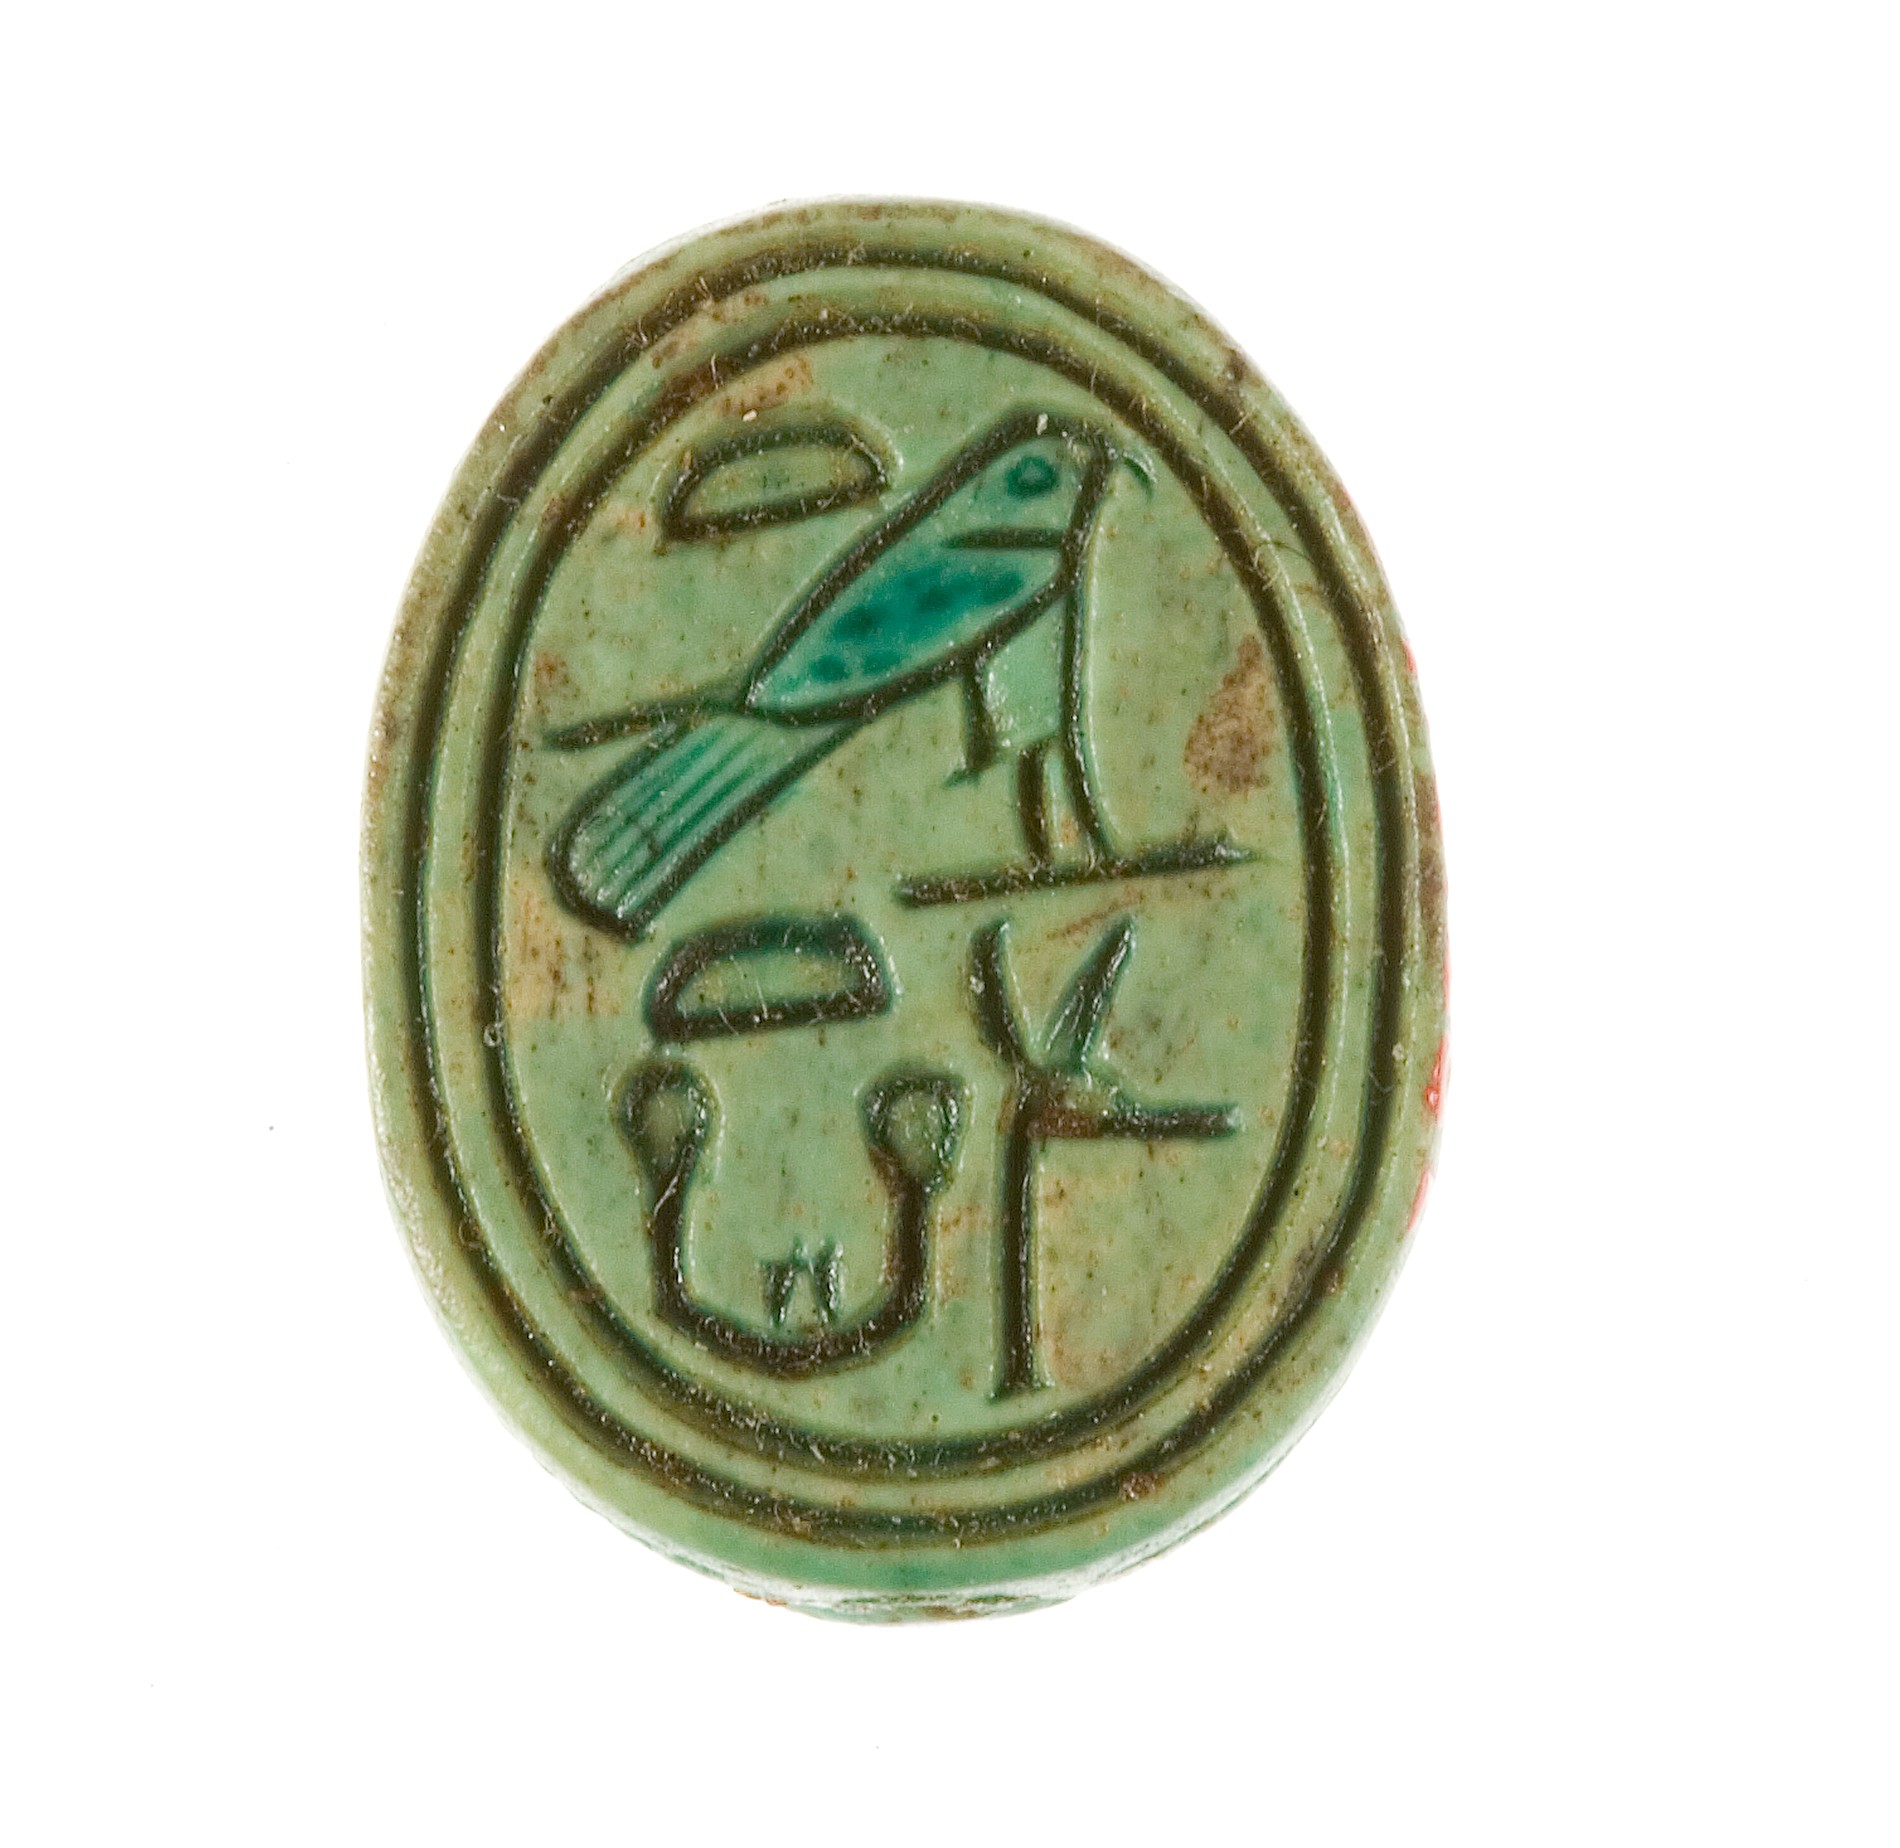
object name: scarab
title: Scarab Inscribed for the Female Horus Wosretkau (Hatshepsut)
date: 1479-1458 BCE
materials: stone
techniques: glazing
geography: egypt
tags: hieroglyphs,scarabs